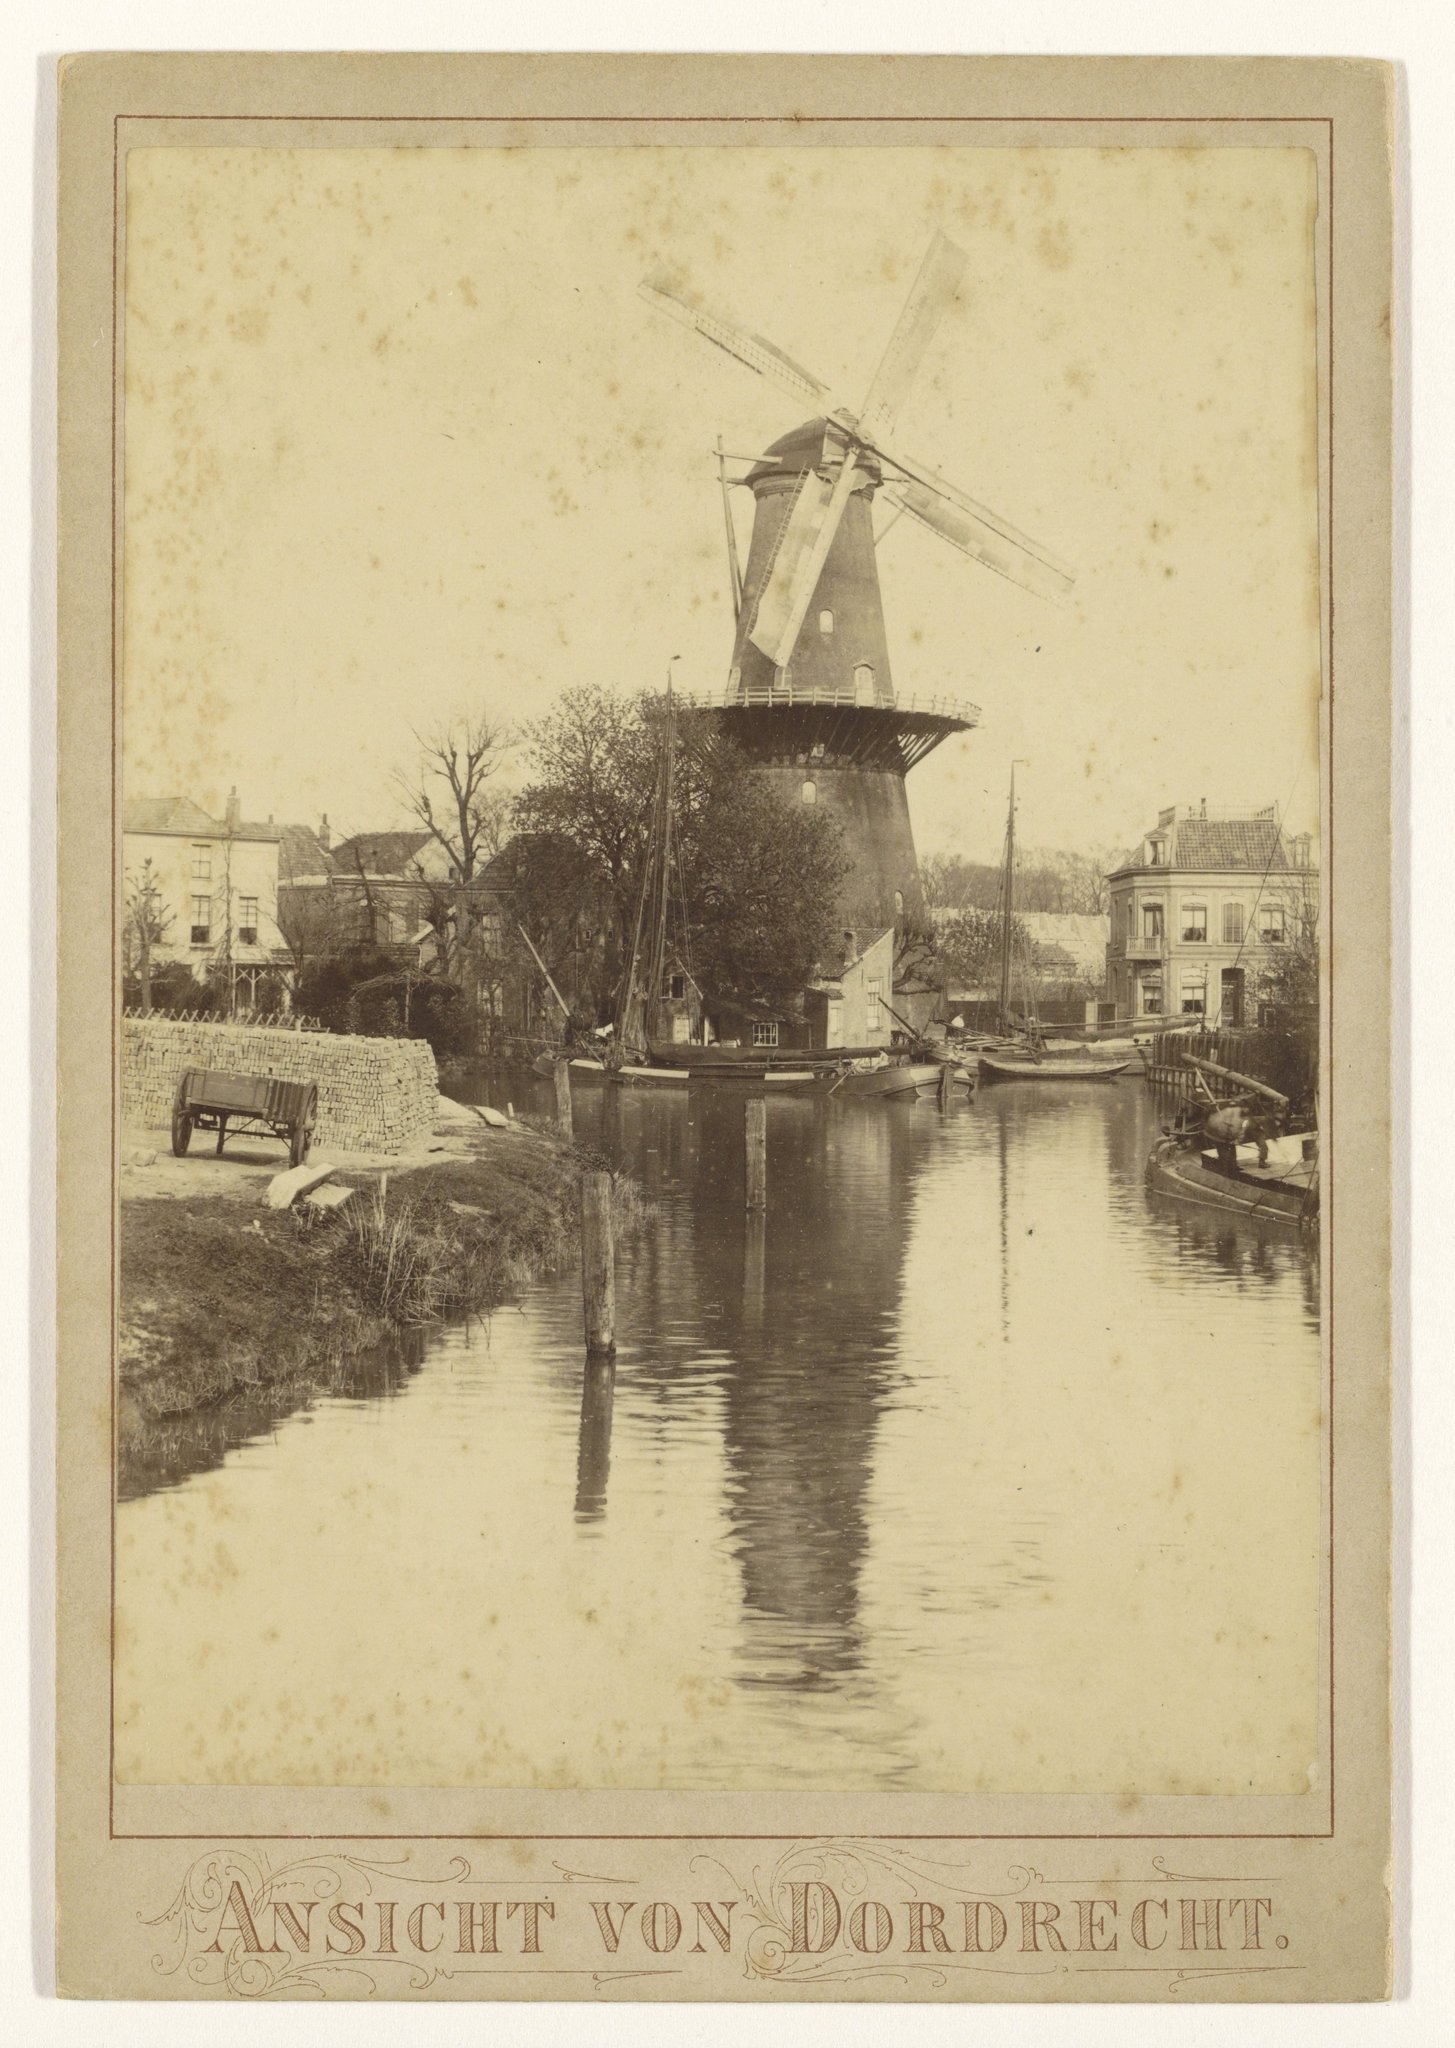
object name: photograph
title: Ansicht von Dordrecht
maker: Anonymous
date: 1860-1890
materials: cardboard, paper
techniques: albumen print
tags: canals, waters (in city), windmill, dordrecht